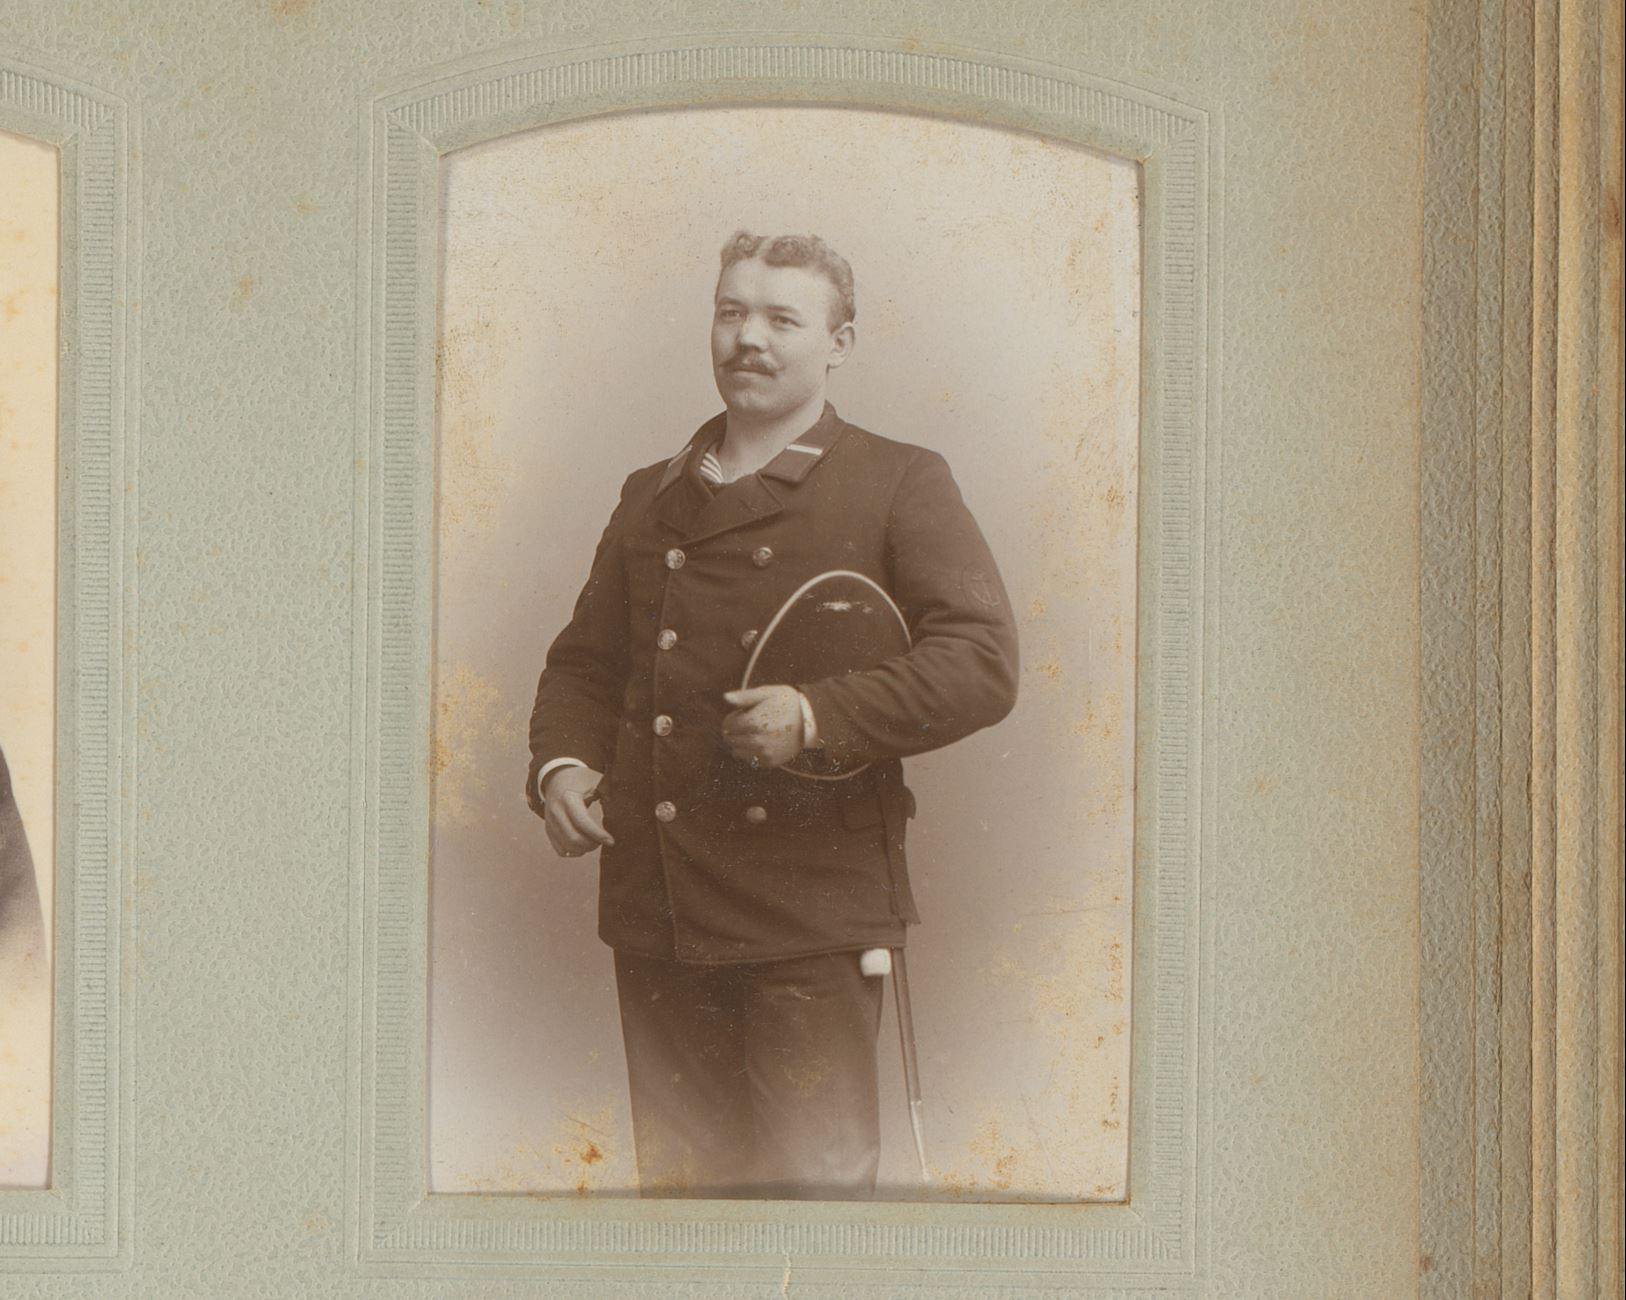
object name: album leaf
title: Portret van een onbekende man in marine-uniform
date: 1895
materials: paper, cardboard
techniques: gelatin silver print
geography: wilhelmshaven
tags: adult man, ranks in the navy, anonymous historical person portrayed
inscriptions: inscription: ‘Atelier Walther/ Wilhelmshaven/ Roonstr. 74b’, monogram: ‘AW’, inscription: ‘Atelier Walther/ Wilhelmshaven/ Roon-Str. 74b./ Die Platte bleibt für Nachbestellungen/ 2 Jahre aufbewahrt.’